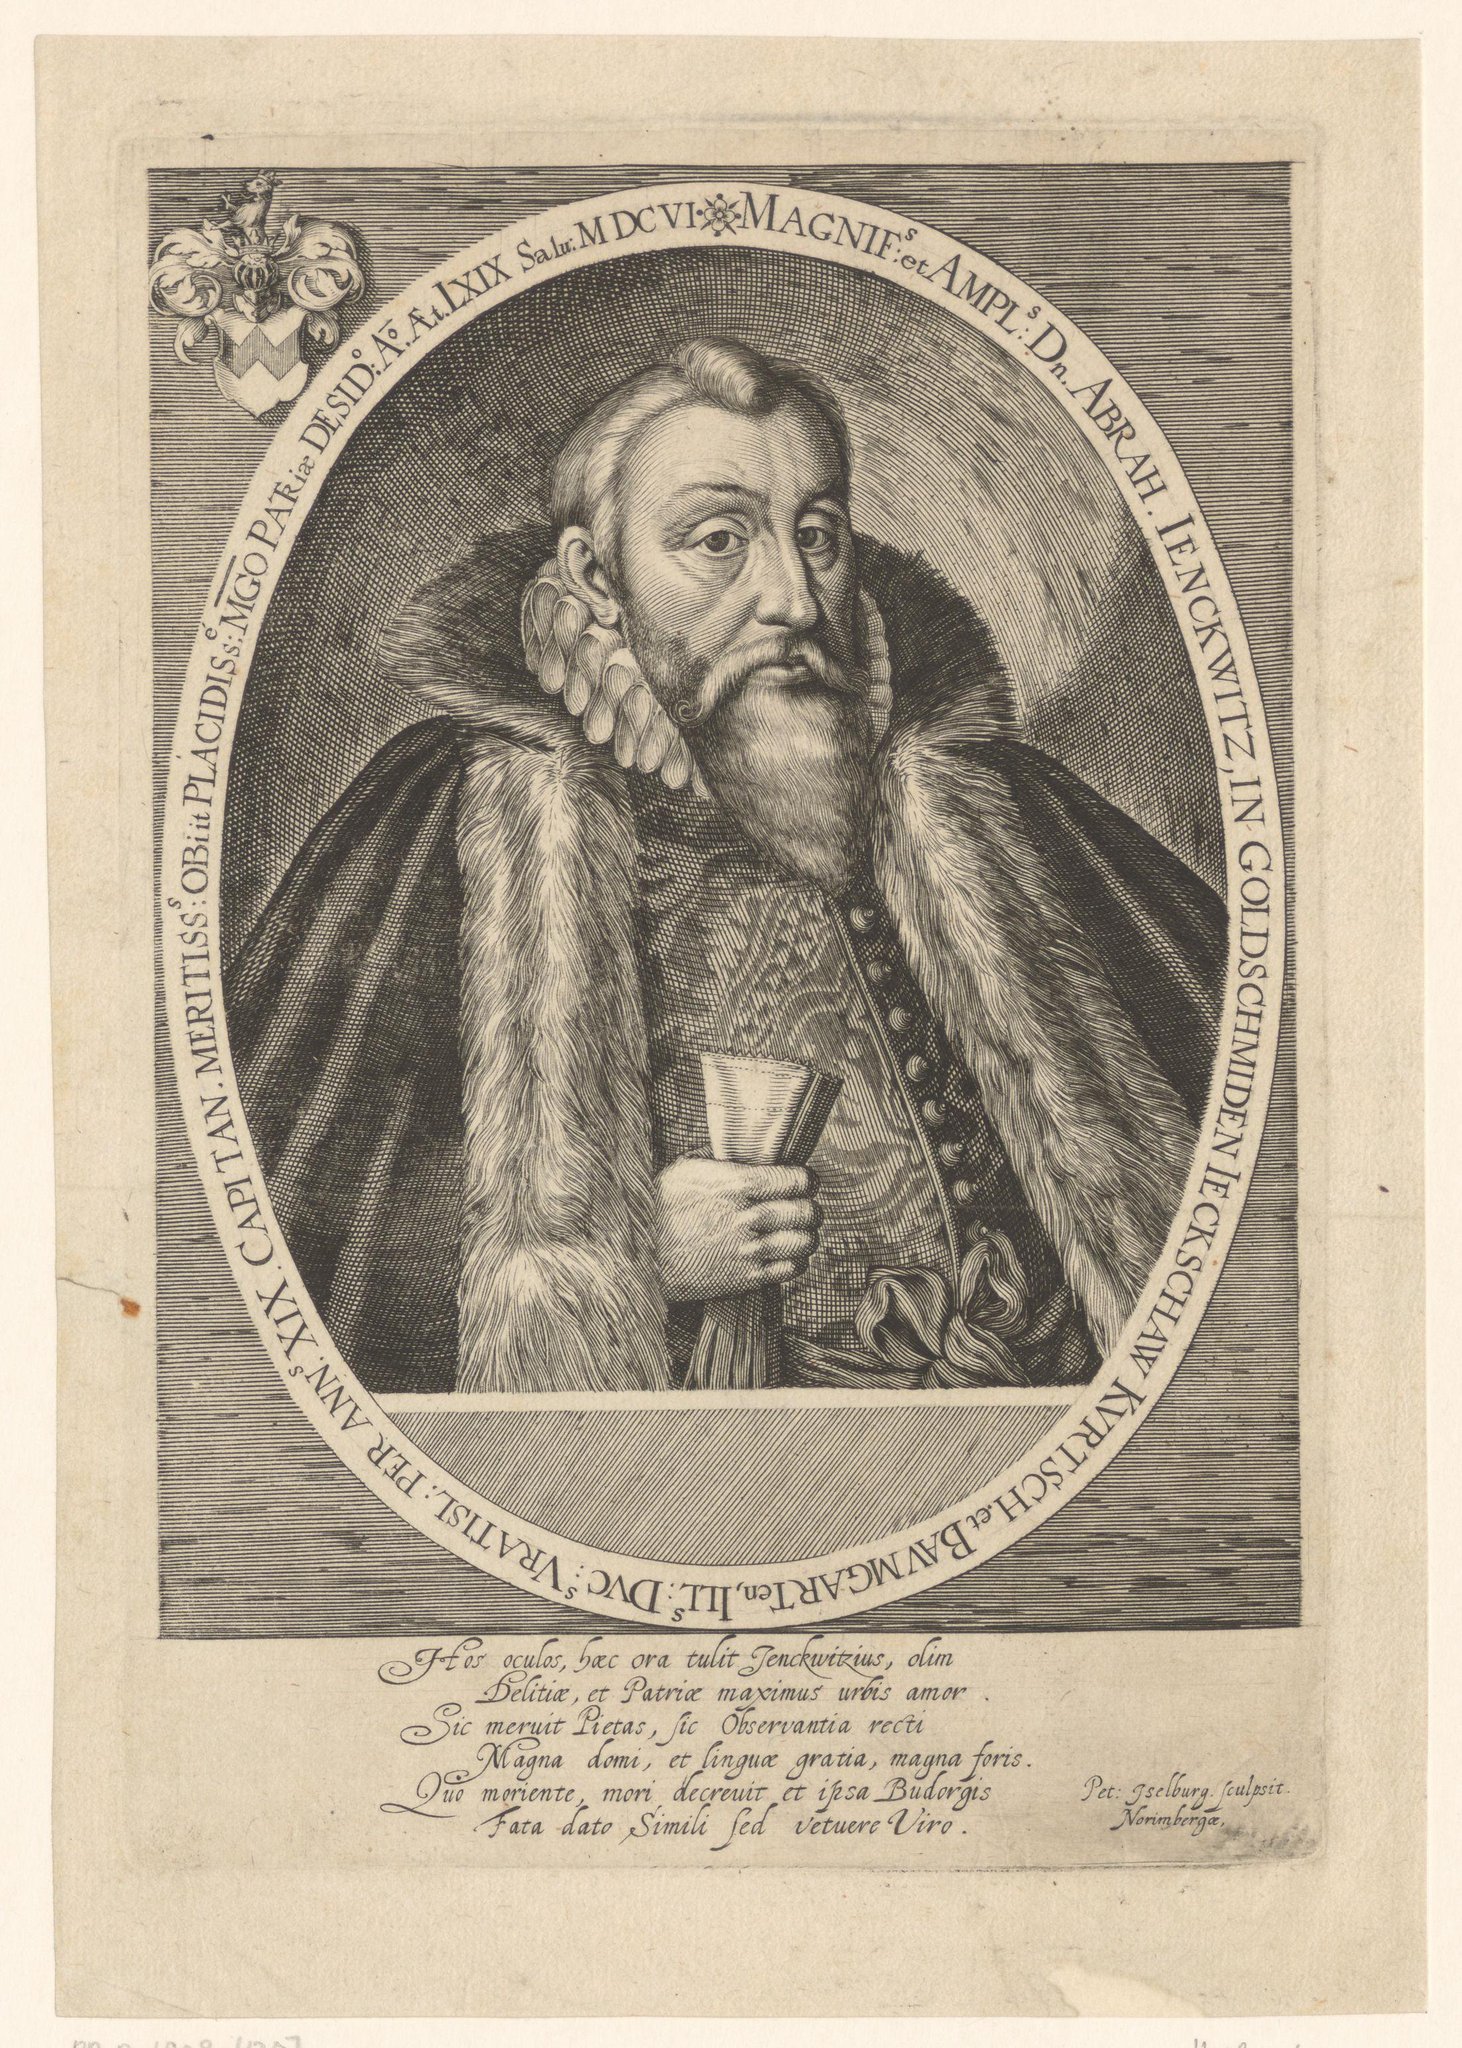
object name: print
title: Portret van Abrahem Jenckwitz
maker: peter isselburg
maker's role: print maker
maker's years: 1568-1630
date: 1578-1630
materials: paper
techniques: engraving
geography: nuremberg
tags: commander-in-chief, general, marshal, historical persons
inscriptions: collector's mark: Lugt 2228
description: Tekst in het Latijn in de omlijsting en in de marge.